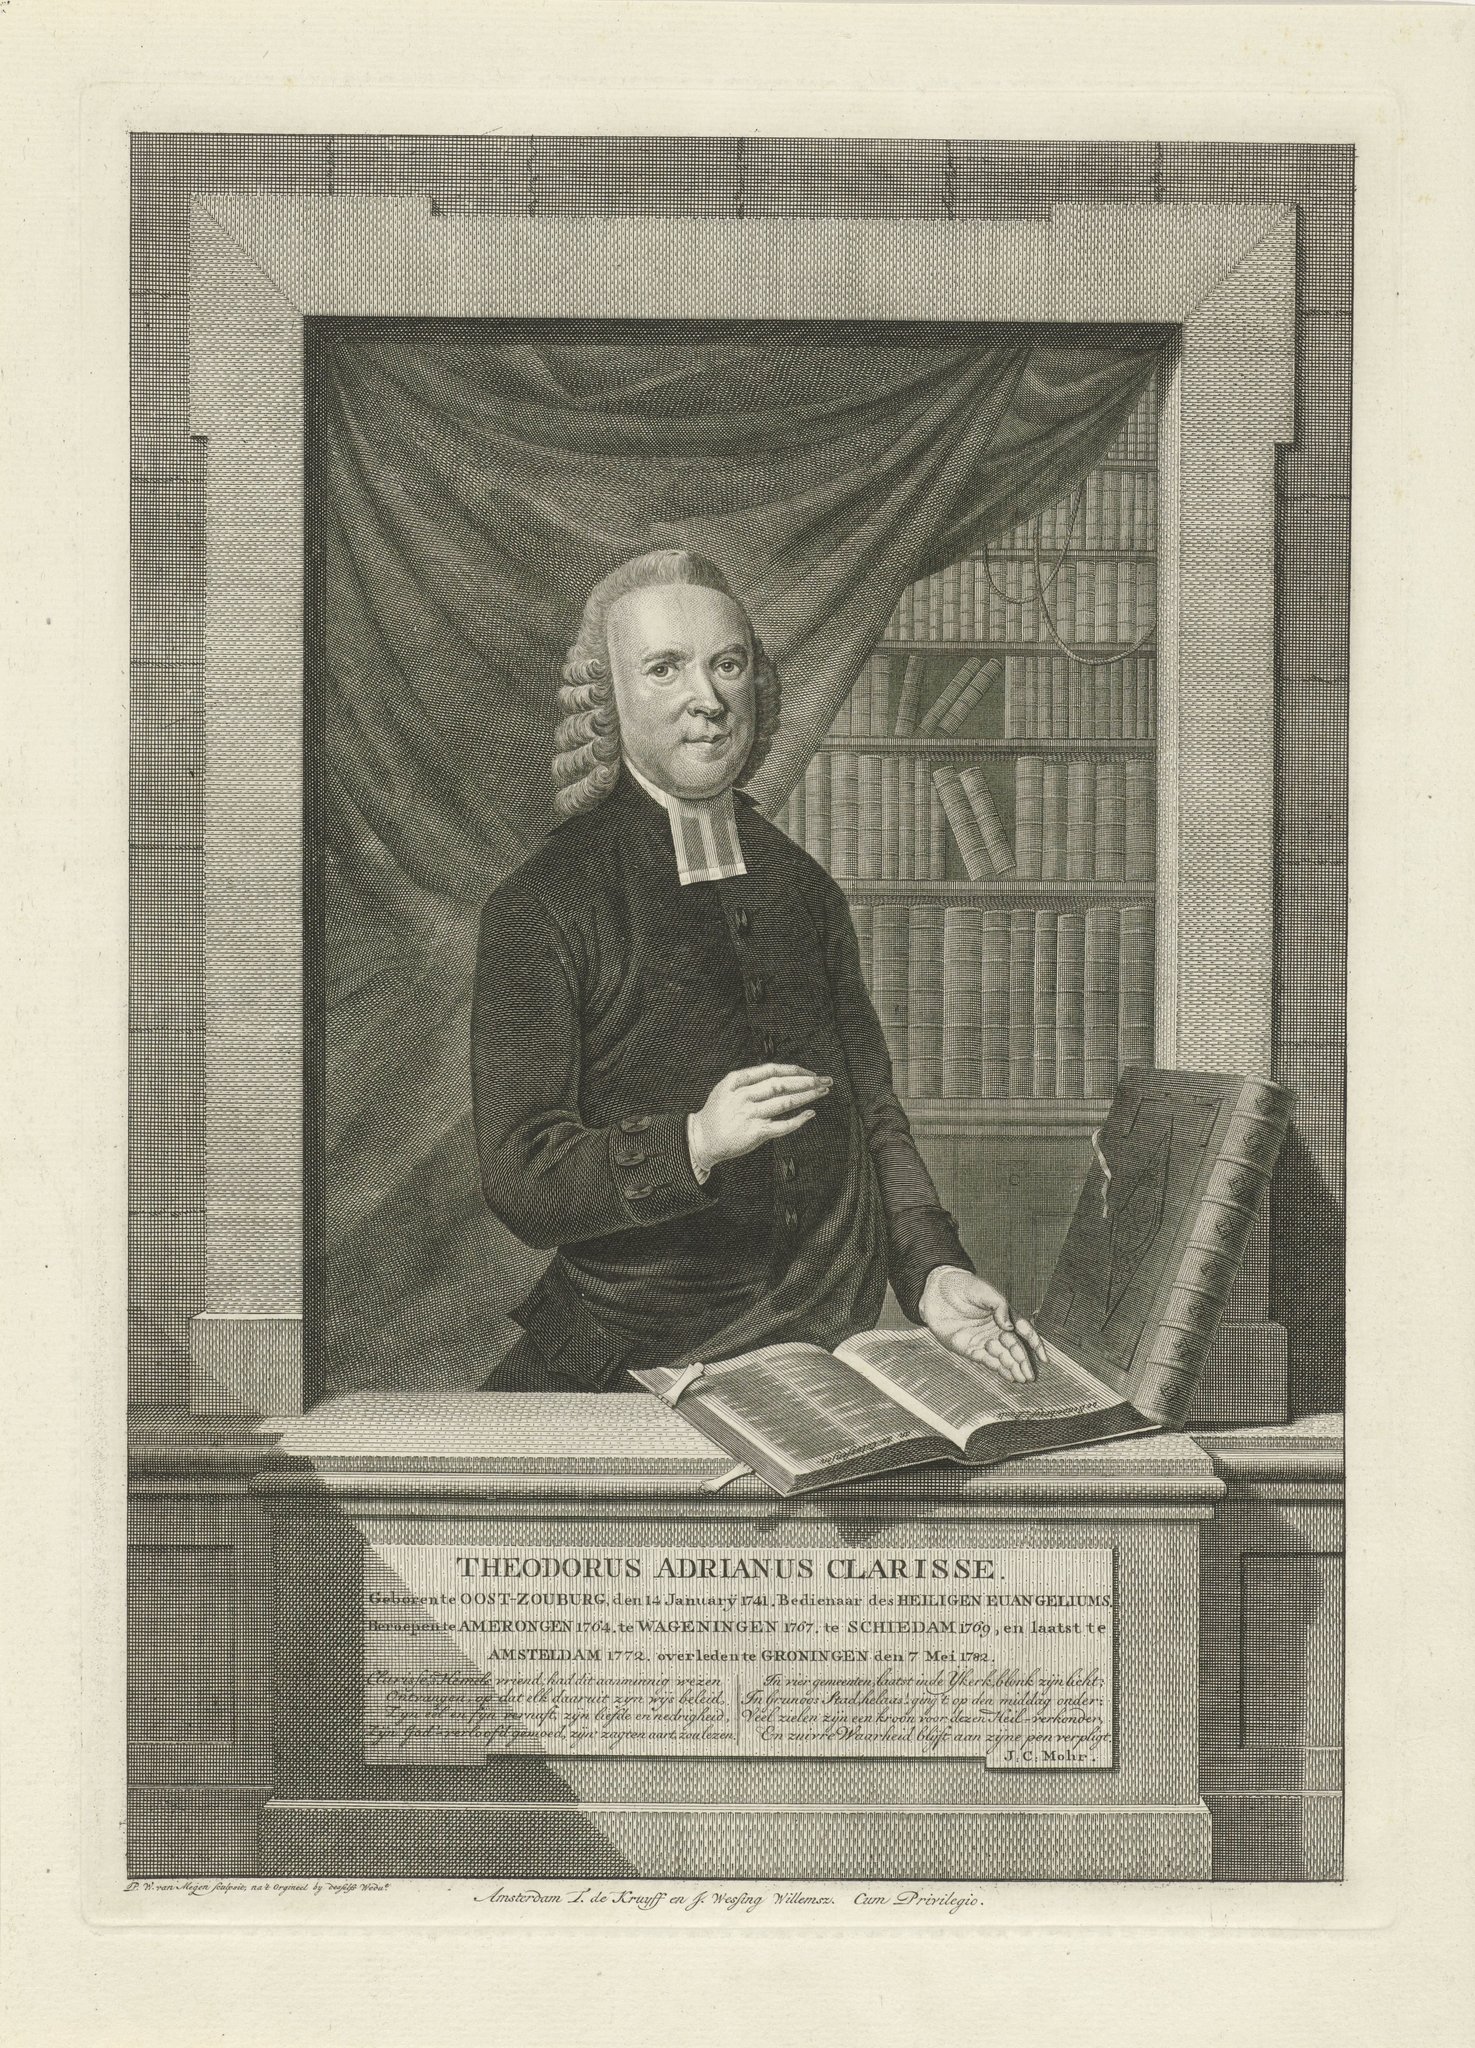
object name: print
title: Portret van Theodorus Adrianus Clarisse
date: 1782-1784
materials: paper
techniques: engraving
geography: amsterdam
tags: amsterdam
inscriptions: collector's mark: Lugt 2228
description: Portret van Theodorus Adrianus Clarisse, predikant te Amerongen, Wageningen, Schiedam en Amsterdam, staande bij een opengeslagen Bijbel.